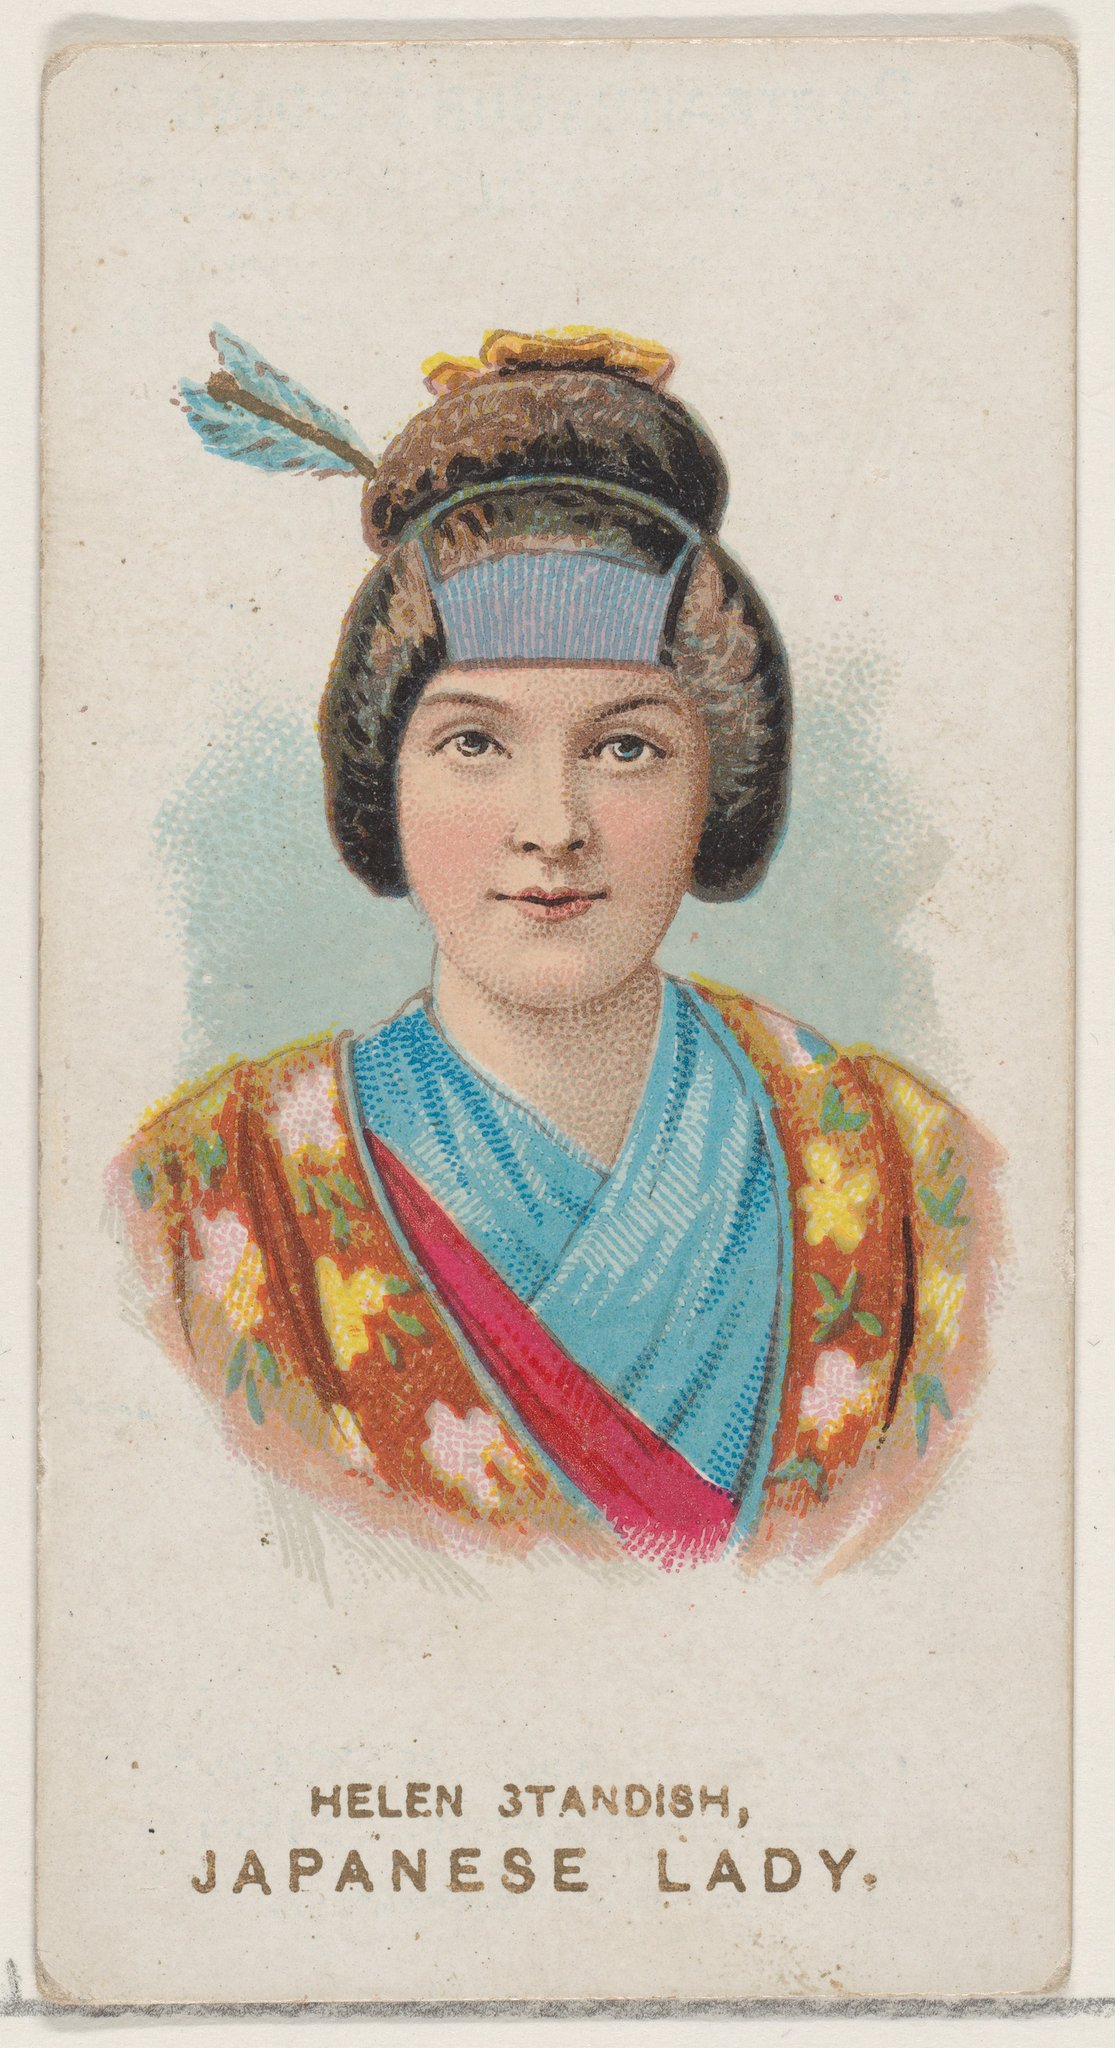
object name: print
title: Helen Standish Dressed as Japanese Lady, from the set Actors and Actresses, Second Series (N71) for Duke brand cigarettes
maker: w. duke, sons & co.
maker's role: publisher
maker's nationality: american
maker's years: 1870-1920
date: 1888-1890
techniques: color lithograph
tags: women,actresses